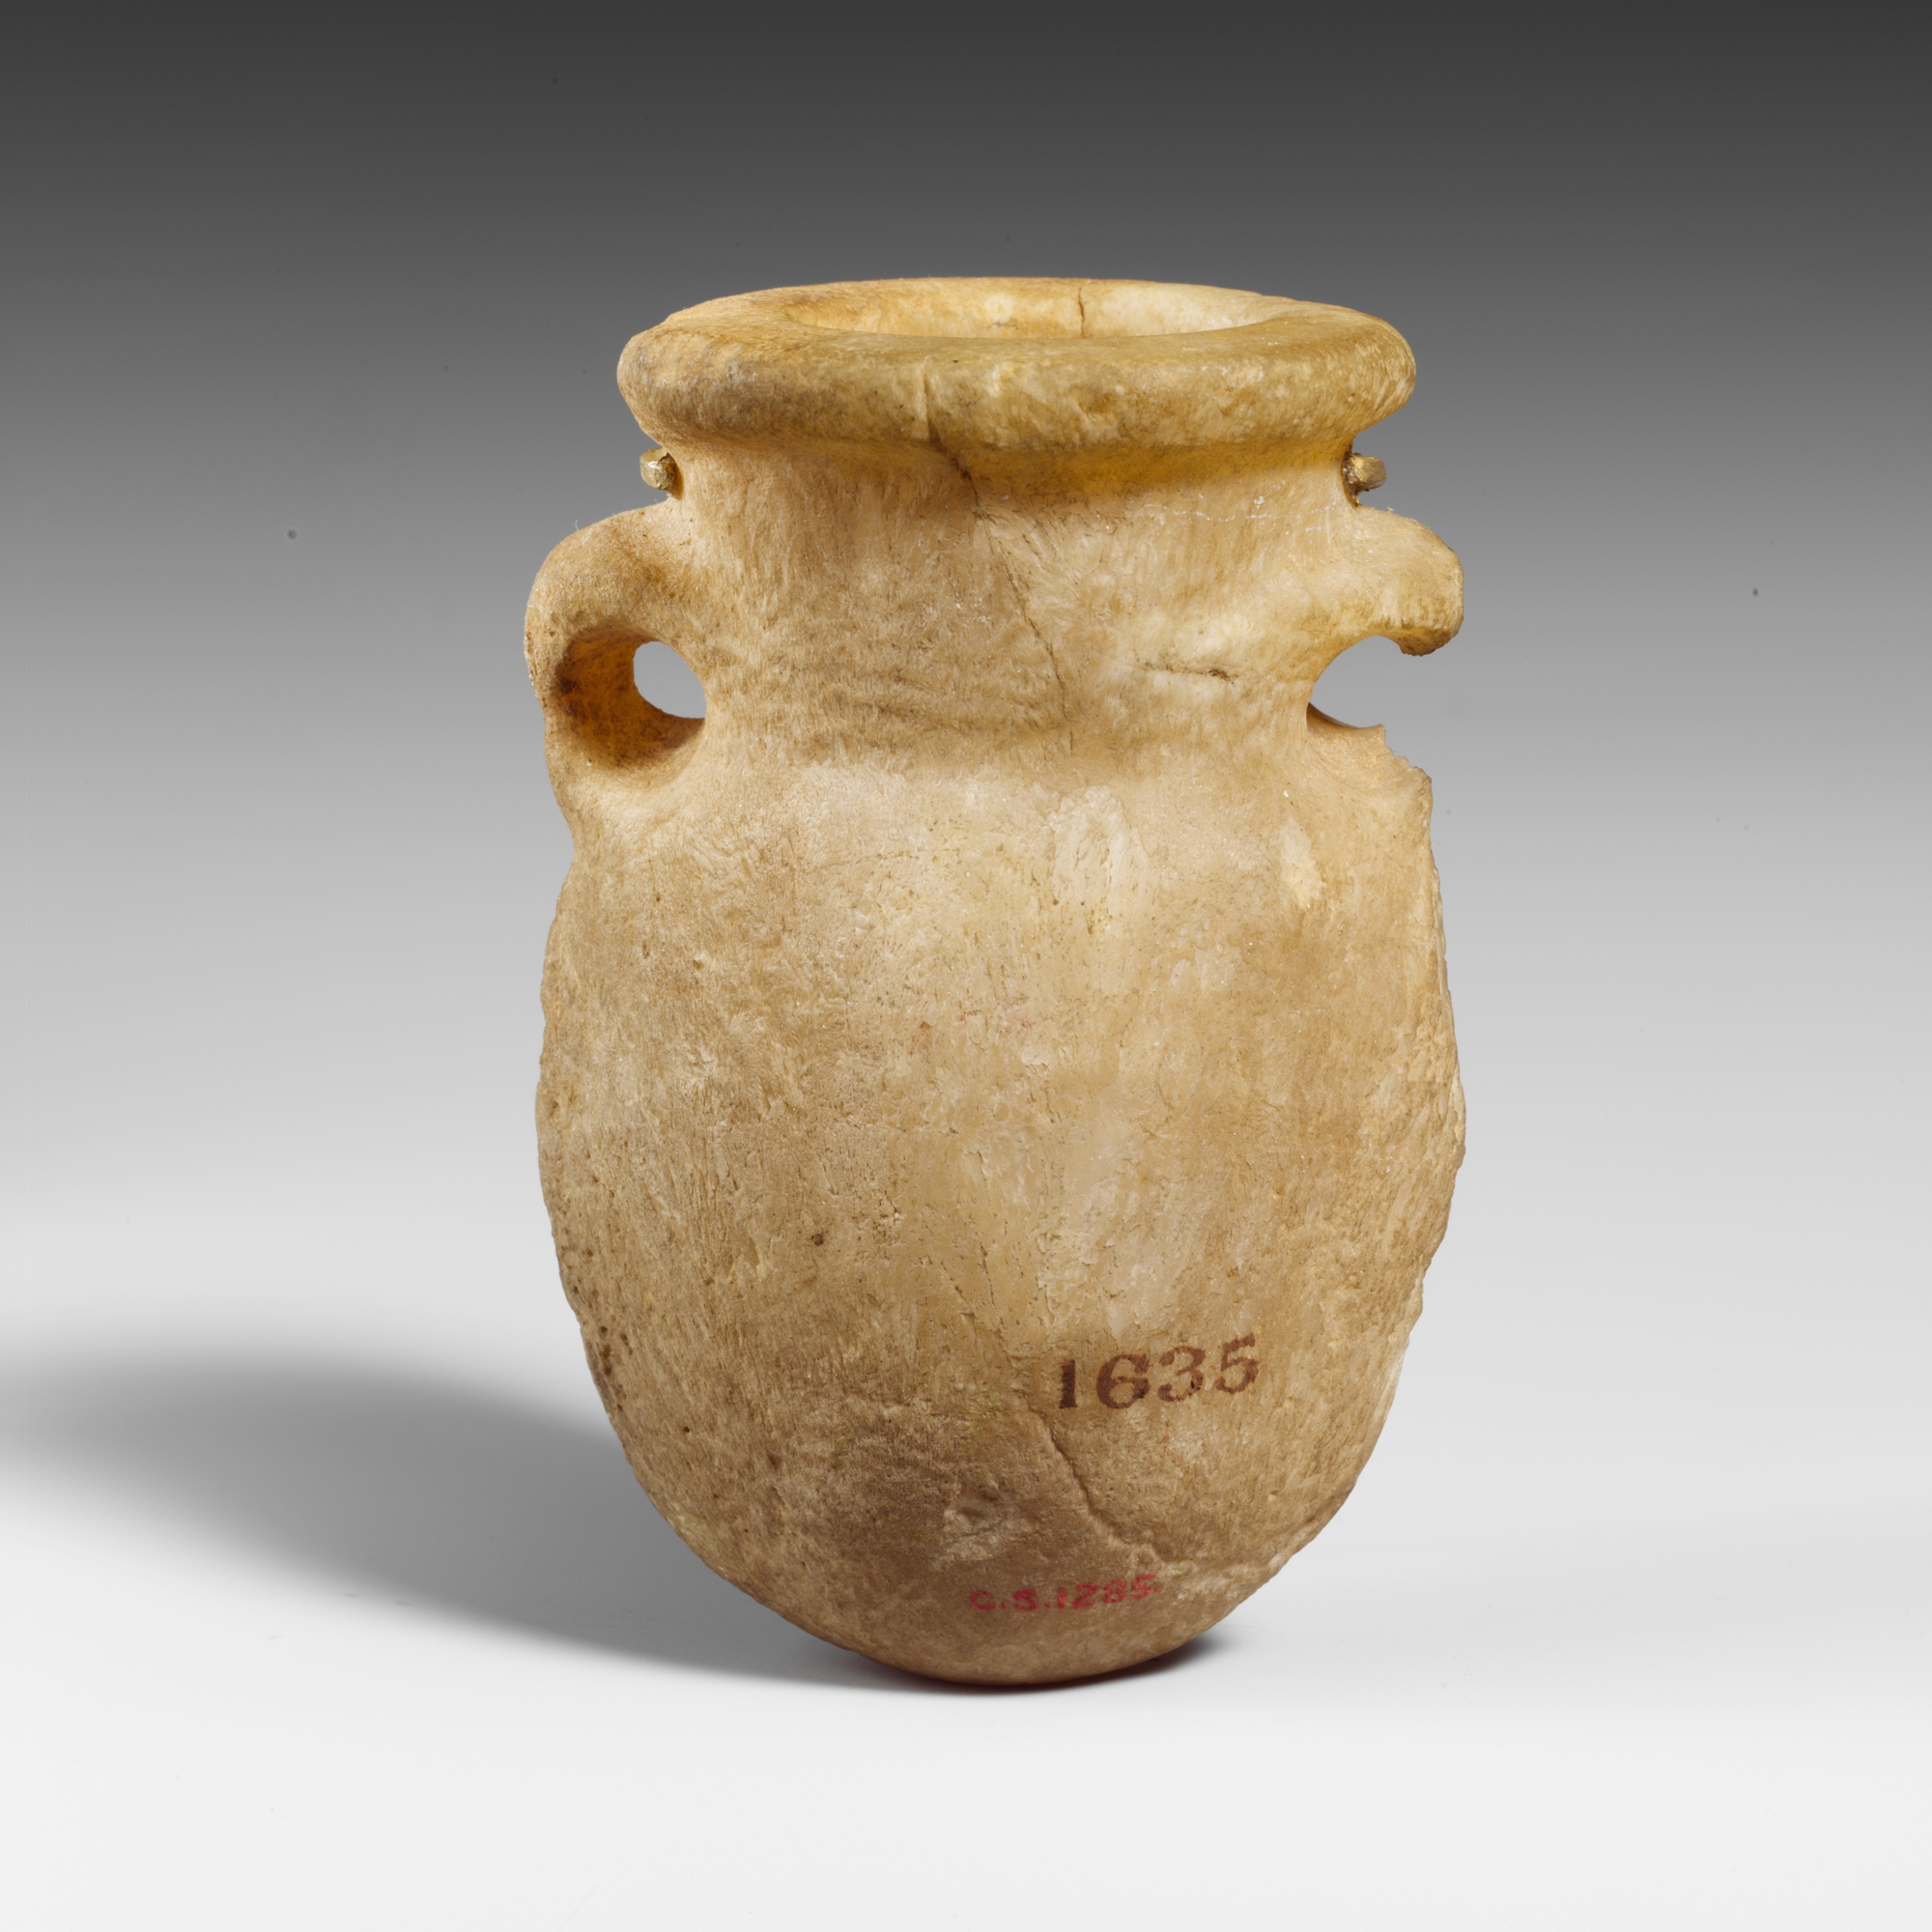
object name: vase, oval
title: Miniature alabaster lentoid flask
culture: cypriot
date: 1600-1200 BCE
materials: alabaster